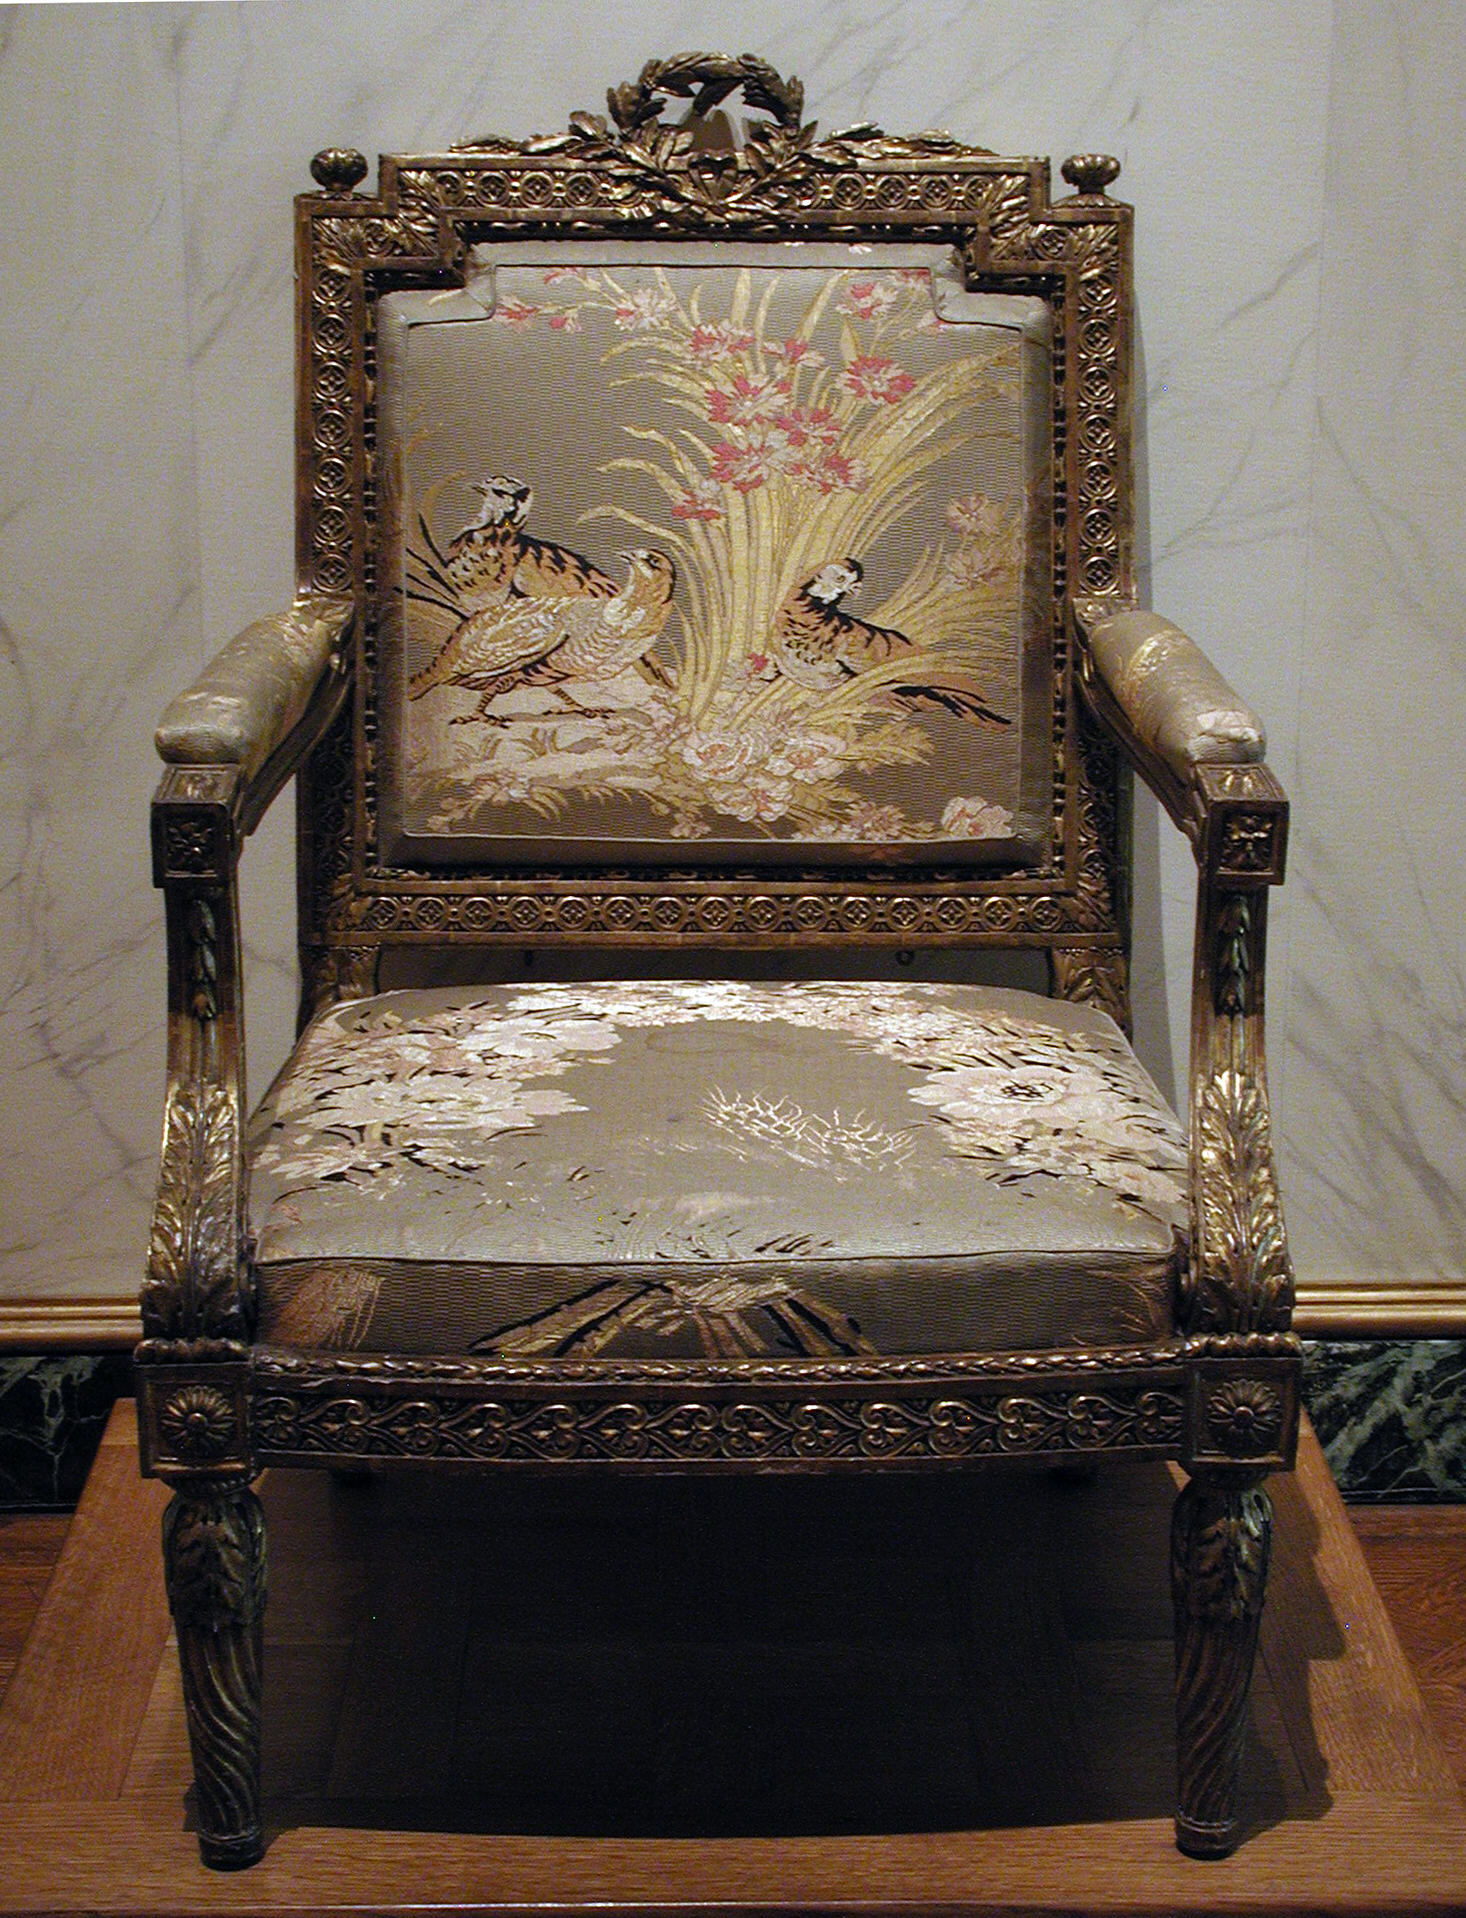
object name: armchair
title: Armchair (one of a pair)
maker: claude chevigny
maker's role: maker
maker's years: 1768-1788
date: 1768-1770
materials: wood, silk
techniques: brocade, carving, gilding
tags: birds,flowers